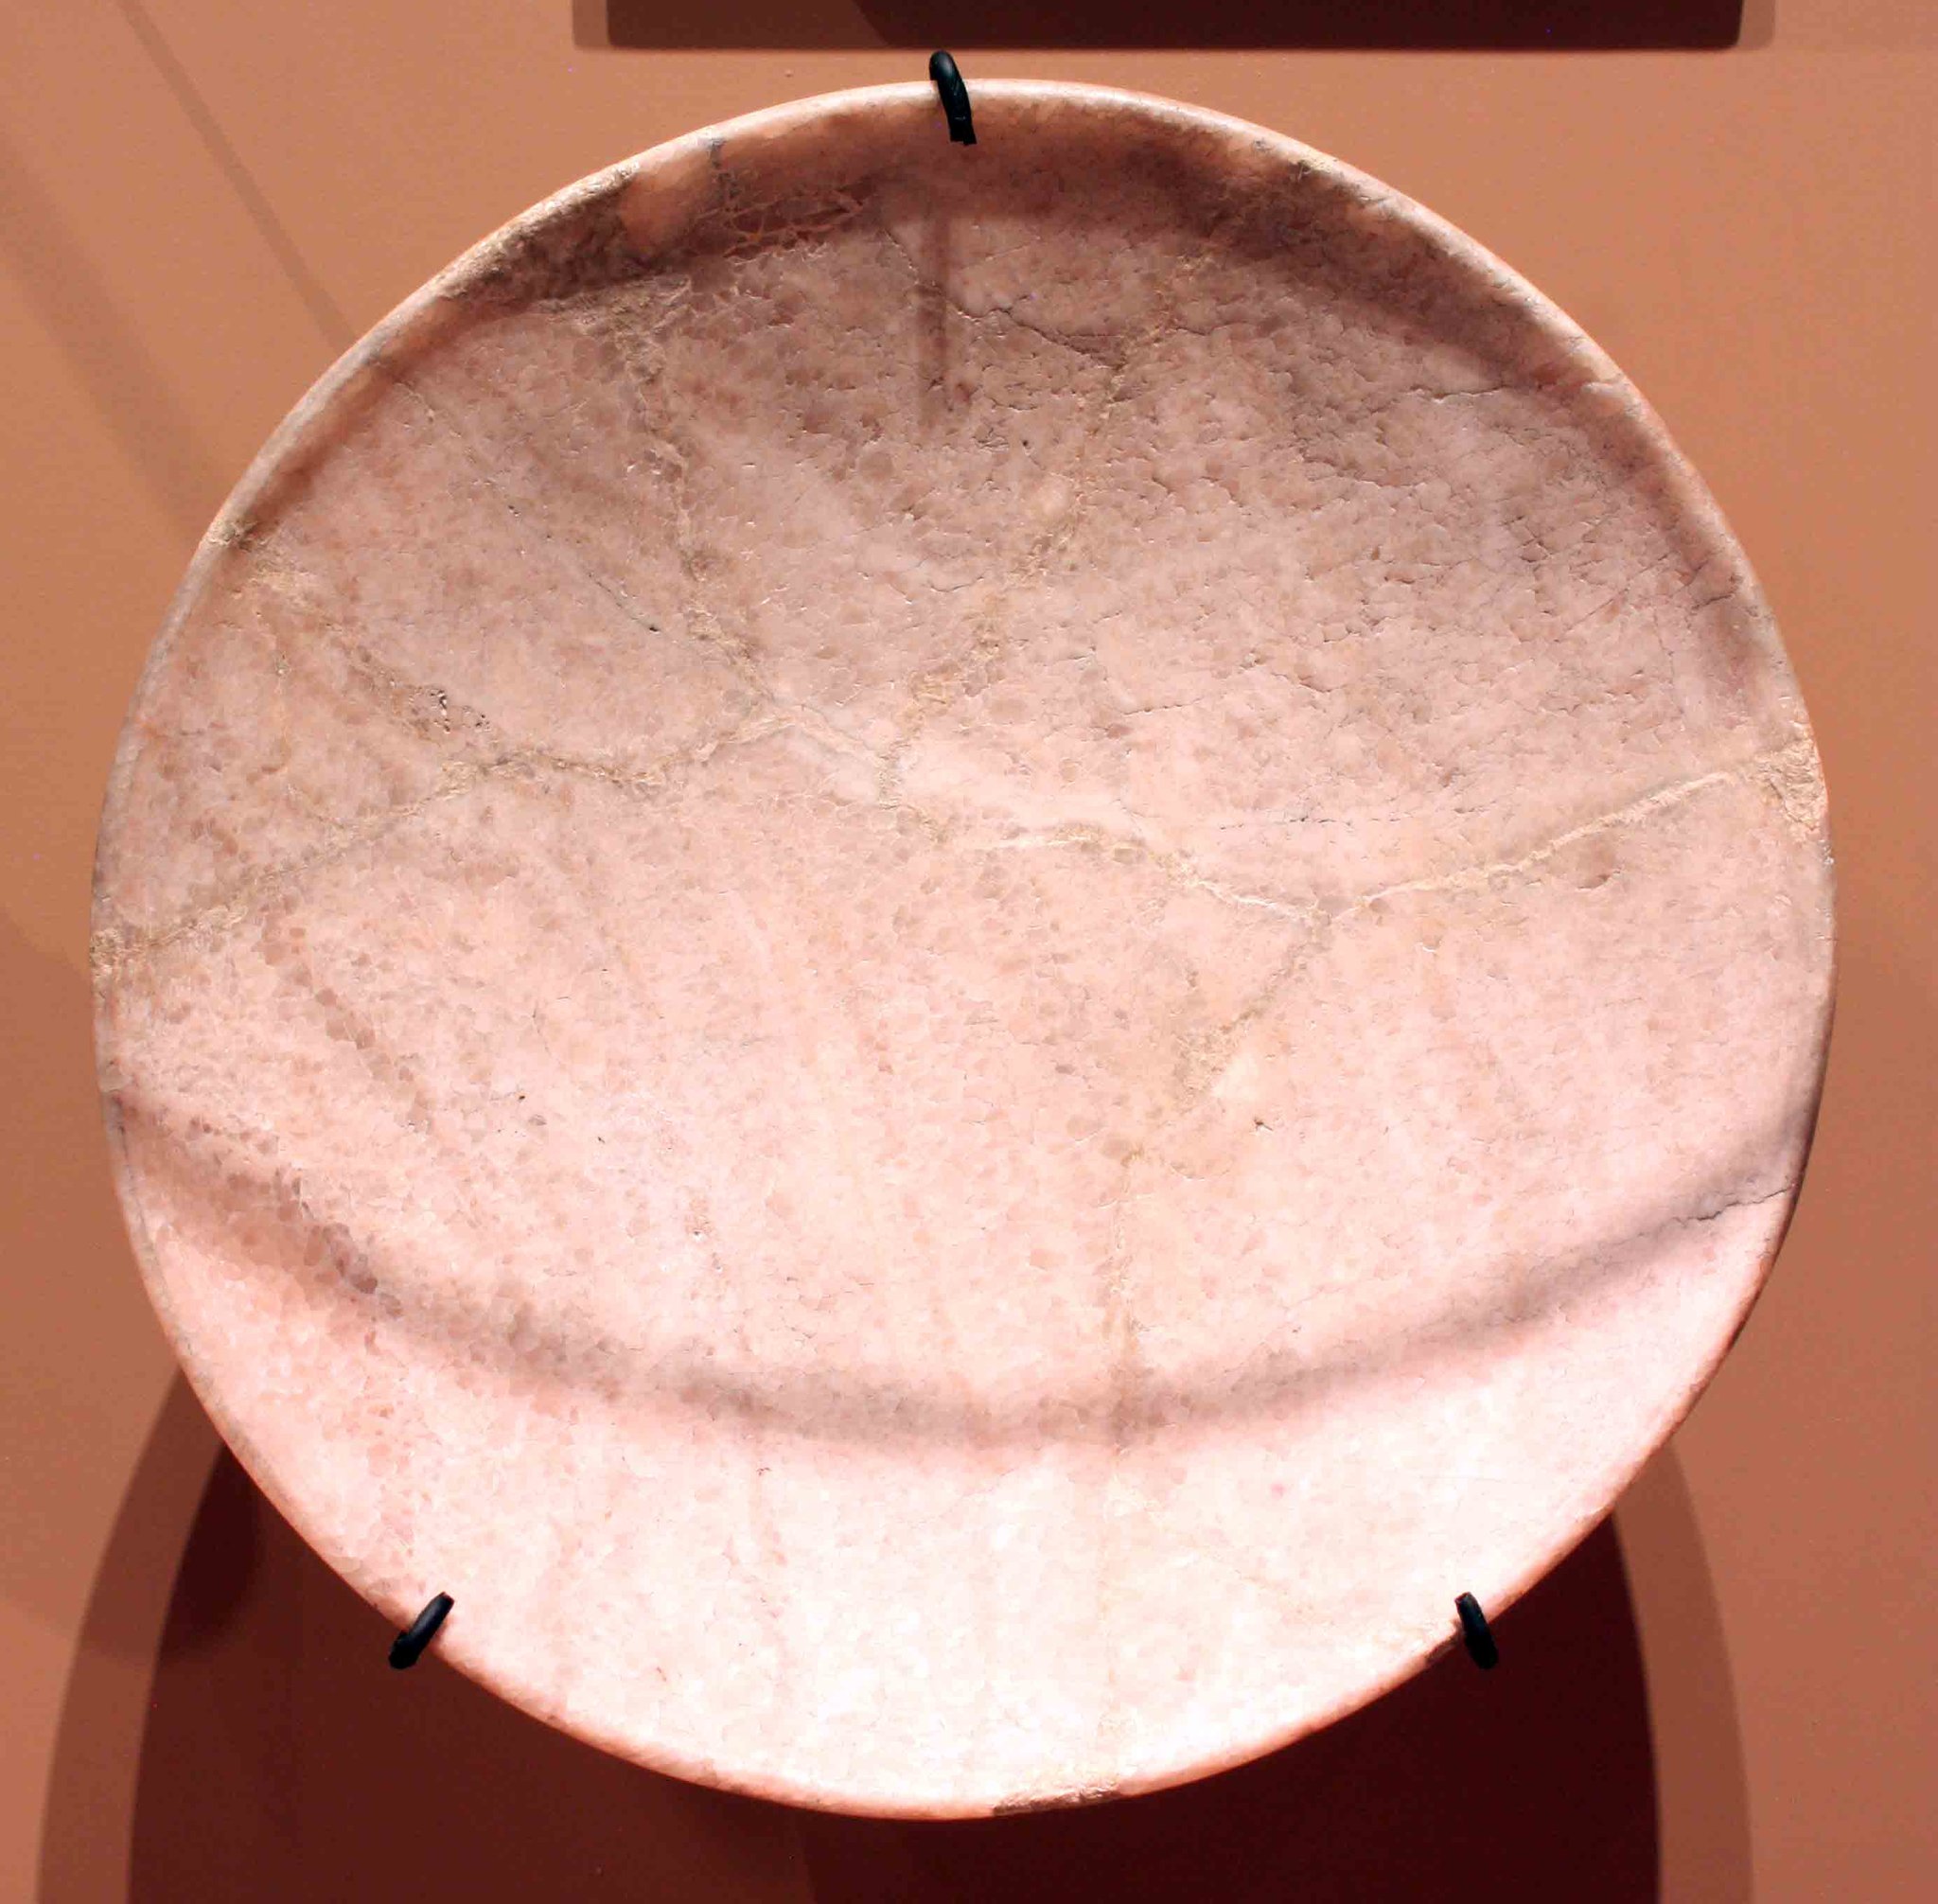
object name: dish, shallow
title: Shallow Dish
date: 2960-2649 BCE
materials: stone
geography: egypt